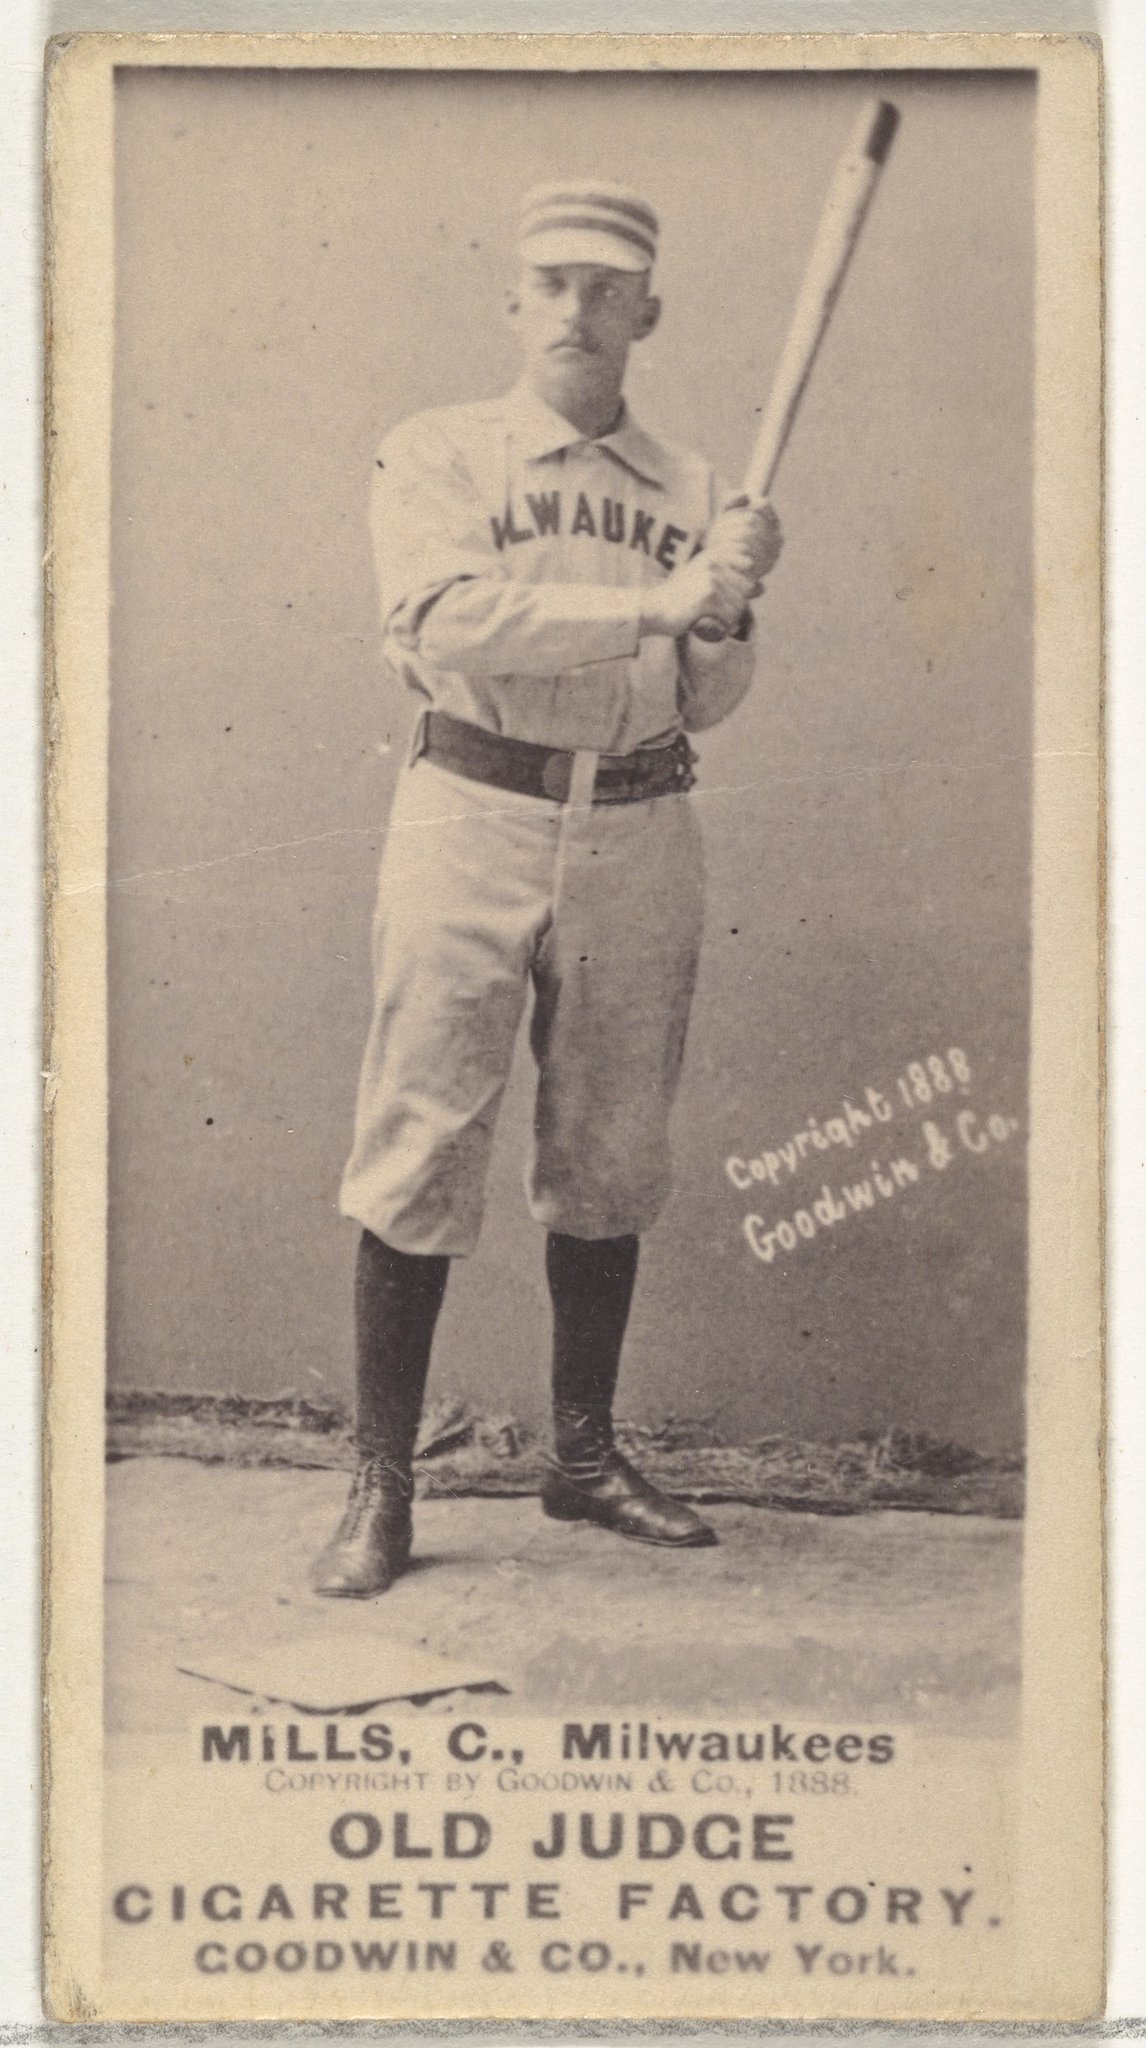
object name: baseball card, photograph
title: Lynn Mills, Catcher, Milwaukee, from the Old Judge series (N172) for Old Judge Cigarettes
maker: goodwin & company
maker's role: publisher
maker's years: 1850-1950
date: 1888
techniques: albumen silver print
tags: men,portraits,baseball,athletes